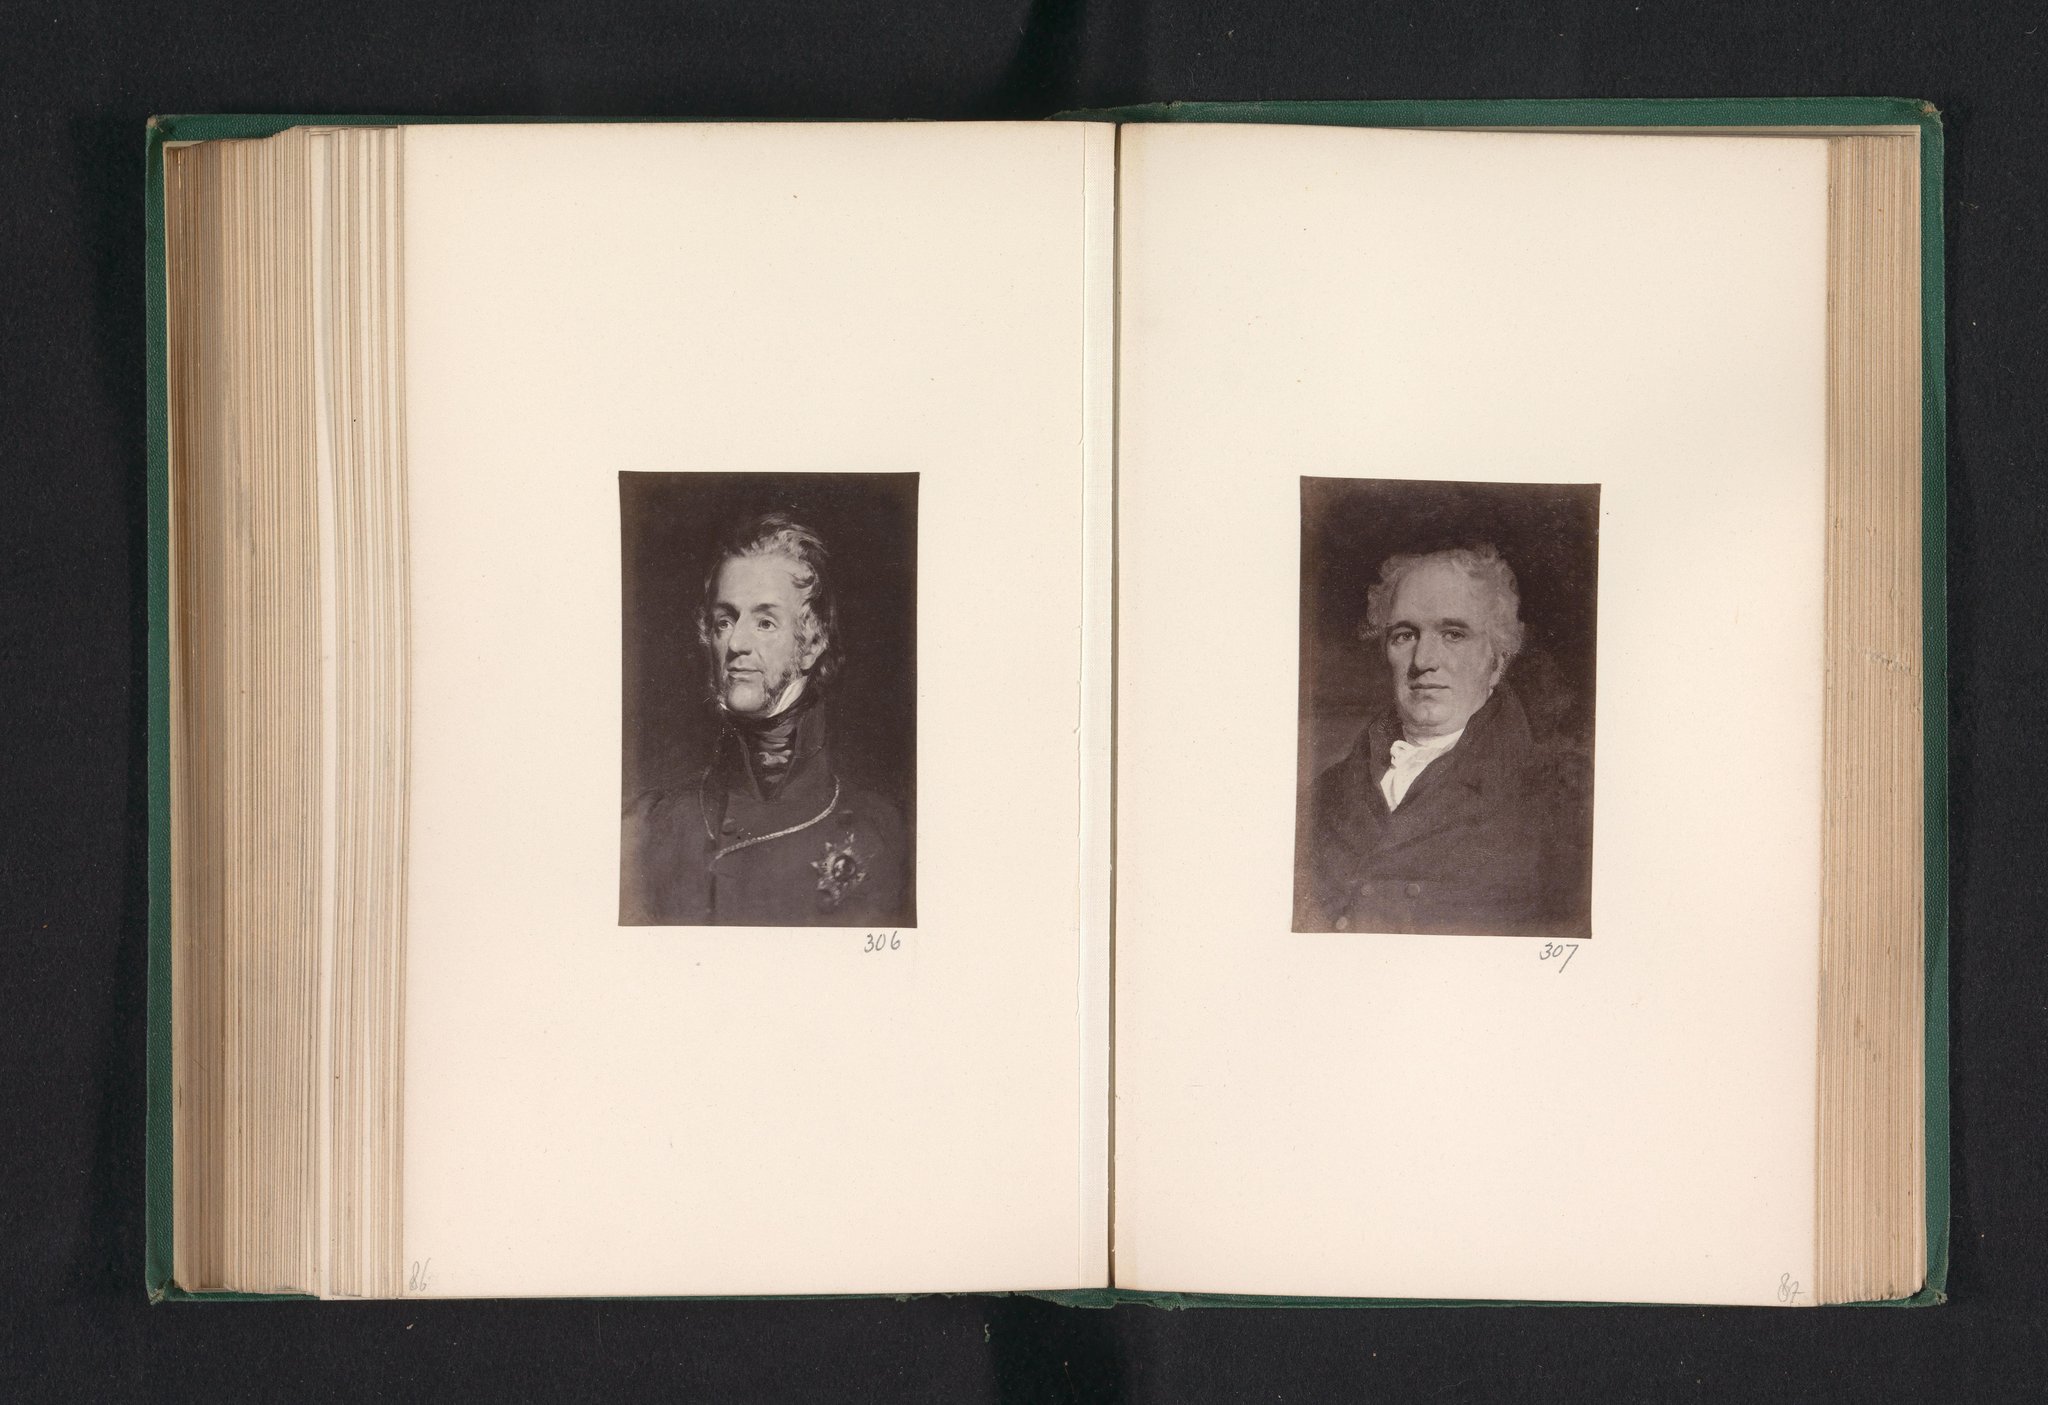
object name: reproduction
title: Fotoreproductie van een schilderij, voorstellende een portret van Kirkman Finlay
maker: thomas annan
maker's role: fotograaf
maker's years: 1829-1887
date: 1863-1868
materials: photographic support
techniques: albumen print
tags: historical persons (portraits and scenes from the life) (+ (full) bust portrait)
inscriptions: number: ‘307’